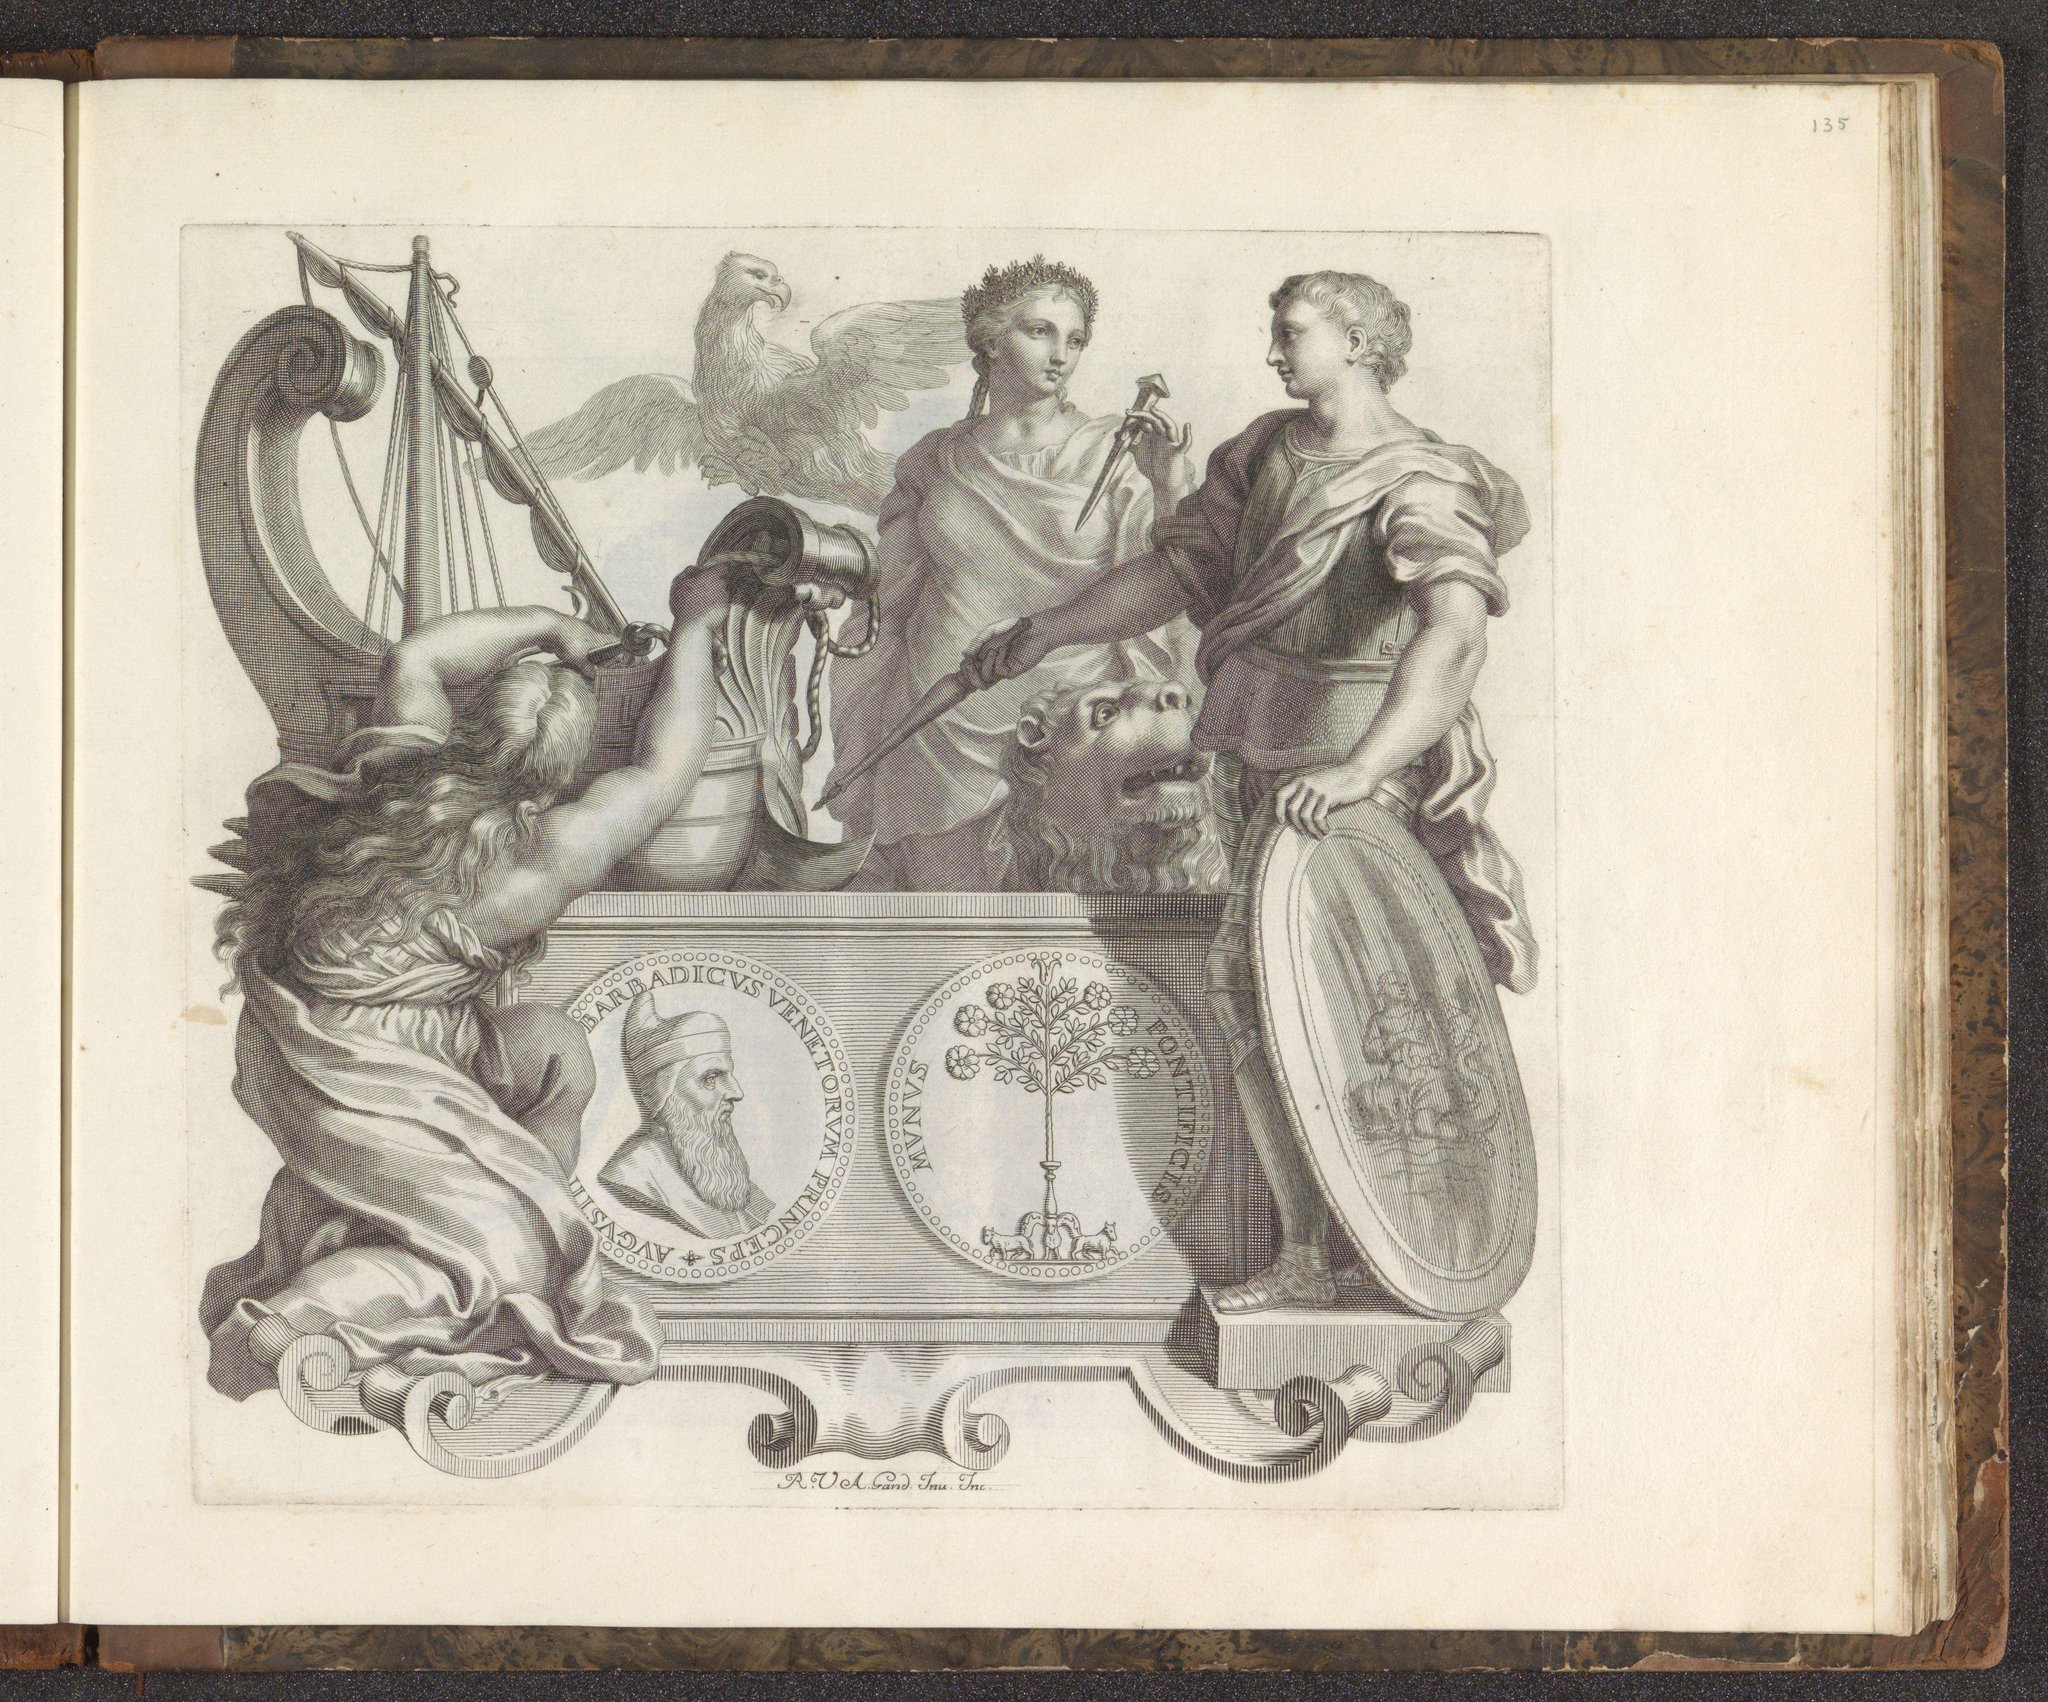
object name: album leaf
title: Portret van Agostino Barbarigo en de personificaties van Vertrouwen, Dankbaarheid en Gunst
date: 1673-1743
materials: paper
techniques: engraving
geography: rome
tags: tools, aids, implements ~ crafts and industries: nail, predatory birds: eagle, confidence, security, tranquillity; 'confidenza', 'sicurezza e tranquillità', 'sicurtà', 'sicurtà o sicurezza', 'tranquillità' (ripa), ships (in general), medal (considered as a piece of sculpture, regardless of its specific function), parts of ship's exterior: anchor, beasts of prey, predatory animals: lion, gratitude; 'gratitudine', 'memoria grata de beneficii ricevuti' (ripa), favour; 'favore' (ripa)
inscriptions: collector's mark: Lugt 2228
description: Voetstuk in de vorm van een cartouche. Daarop een medaillon met op de voorzijde het portret van Agostino Barbarigo met dogehoed. Op de achterkant een tak met zeven bloemen op een voetstuk met dieren. Daarbij de tekst: Munus Pontificis. Het voetstuk wordt omringd door drie personificaties. Links mogelijk de personificatie van Vertrouwen of Zekerheid. Een vrouw leunt aan een schip en heeft met haar handen het anker en touw vast. In het midden staat Dankbaarheid gekroond met een krans van jeneverbessen en in haar hand een grote spijker. Ze staat tussen een leeuw en een adelaar. Rechts de personificatie van de Gunst: een jongeman met een scepter en een schild waarop een kind op de rug van een dolfijn op een lier speelt. De prent maakt deel uit van een album.